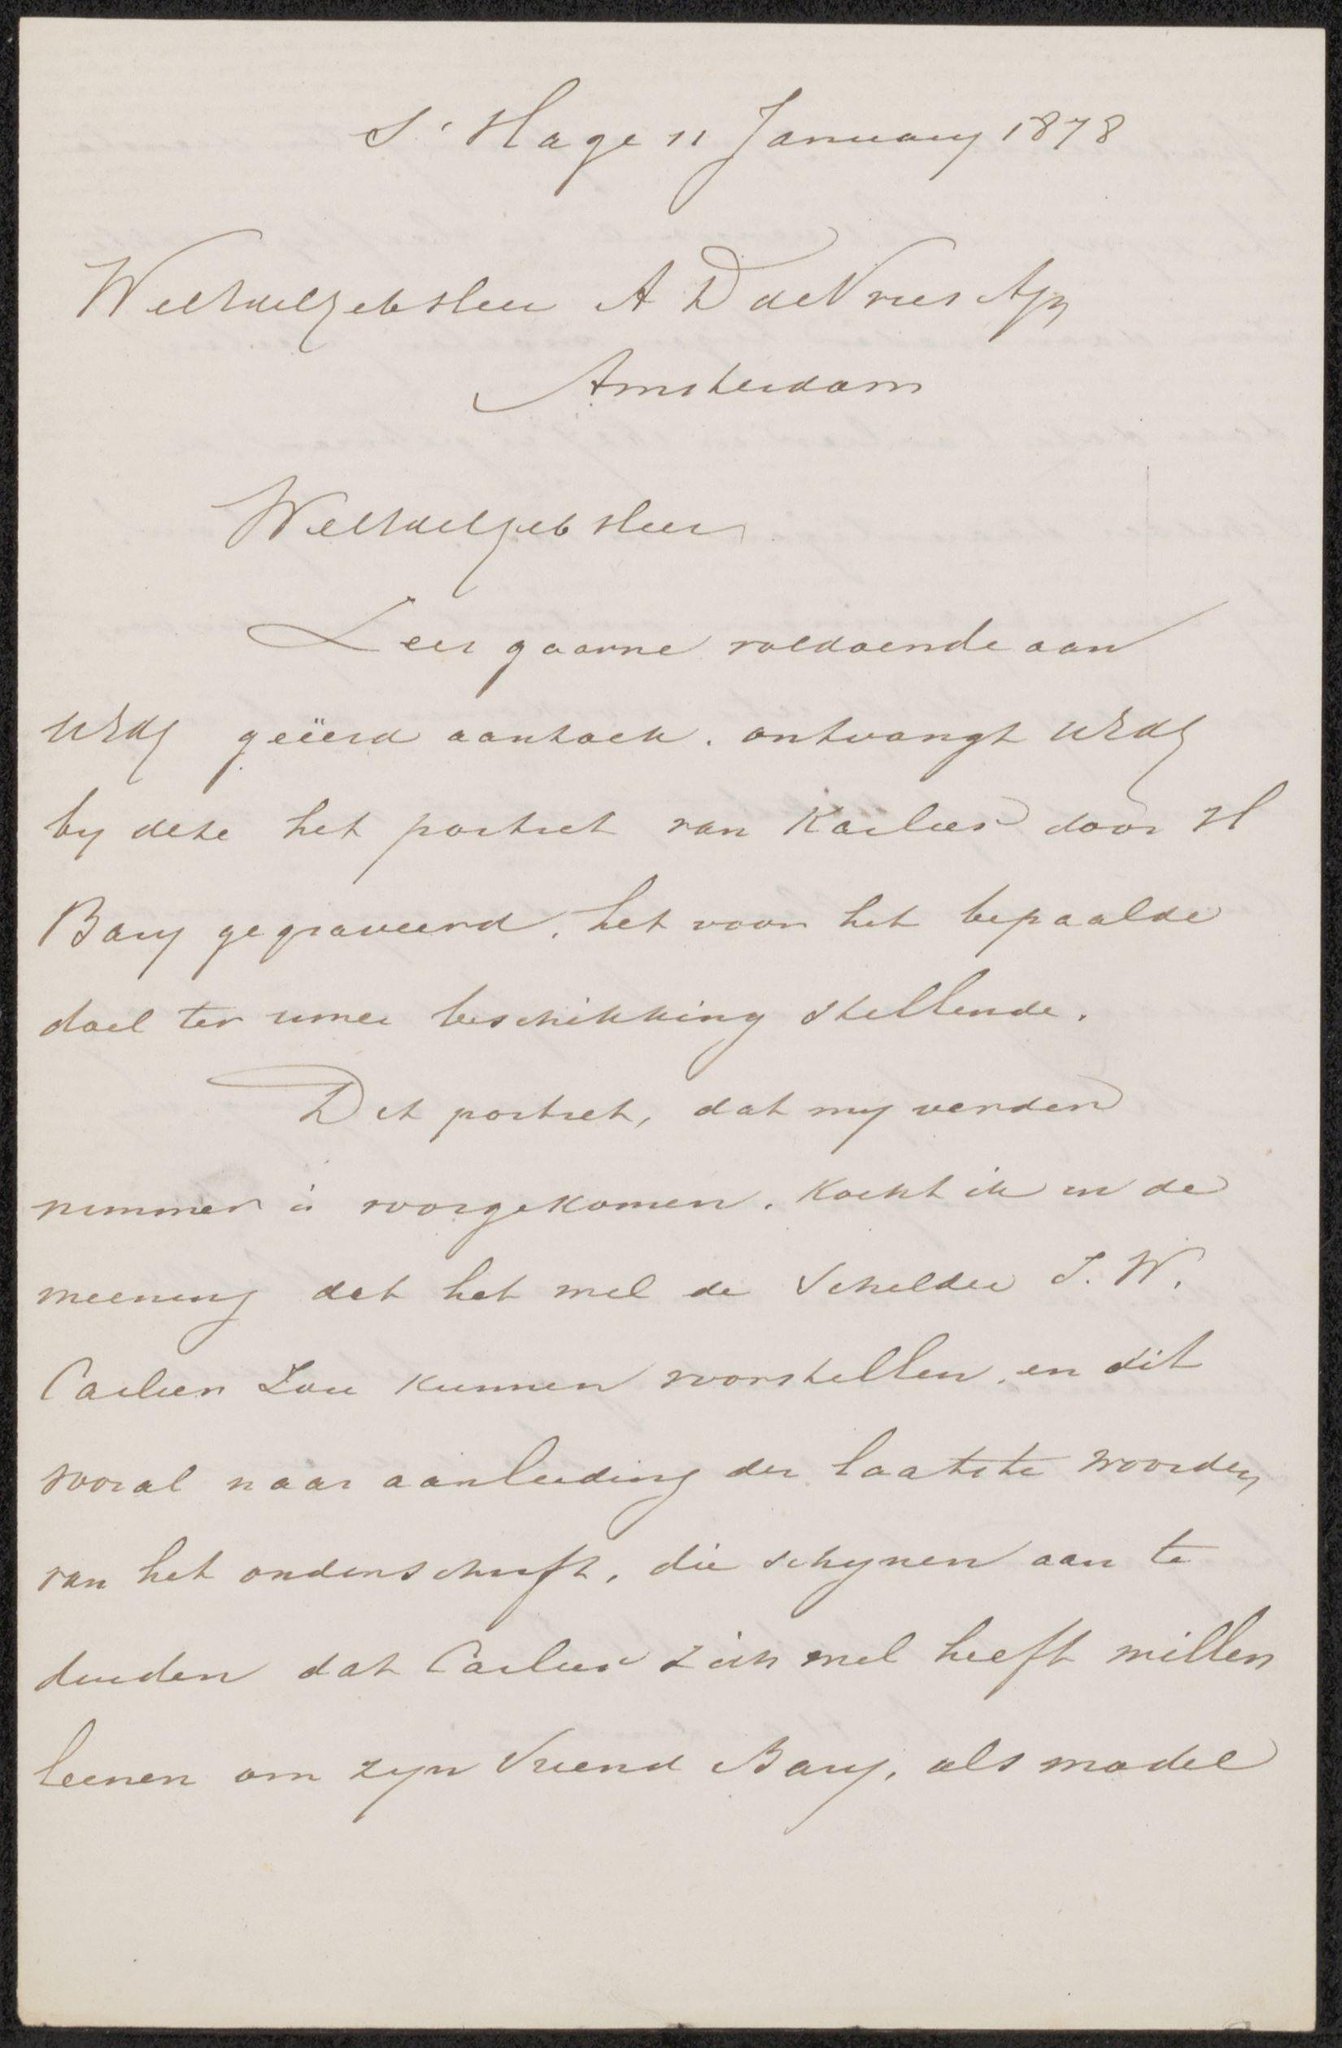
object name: letter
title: Brief aan Adrianus Daniël de Vries Azn.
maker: lambertus hardenberg (1822-1900)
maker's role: draughtsman, painter, print maker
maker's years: 1822-1900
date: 1878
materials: ink, paper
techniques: pen, writing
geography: the hague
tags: gouda, print maker, draughtsman, hendrik bary, amsterdam, the graphic arts, historical persons (portraits and scenes from the life)